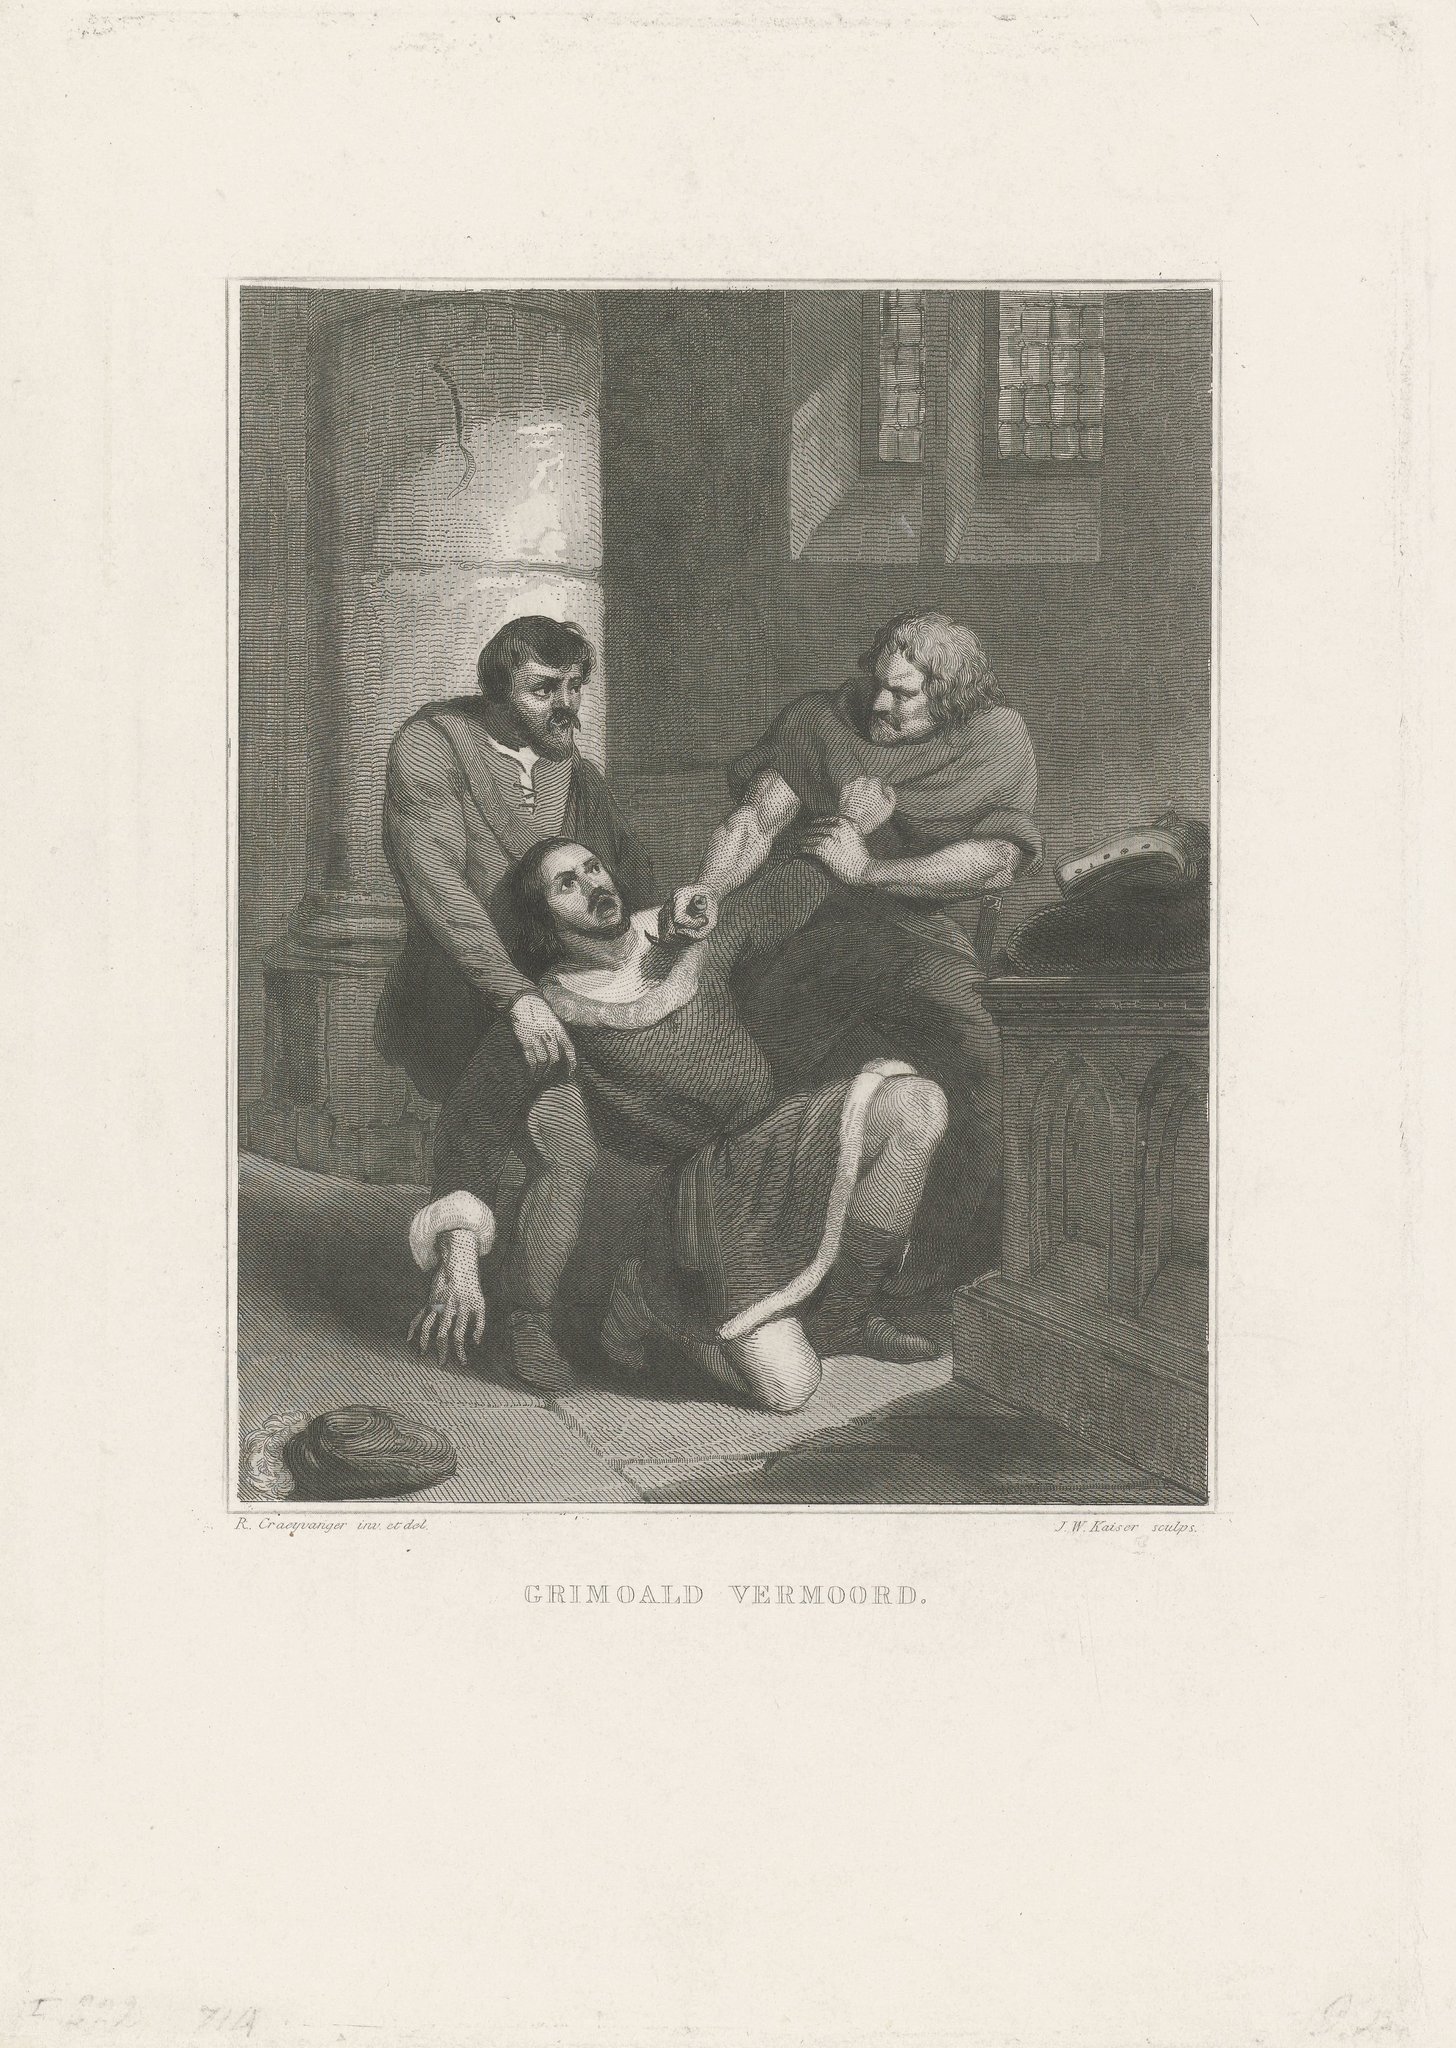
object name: book illustration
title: Grimoald vermoord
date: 1840-1884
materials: paper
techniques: etching, roulette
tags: murder, liège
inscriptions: collector's mark: Lugt 2228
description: Illustratie in: Arend, Johannes Pieter. Algemeene geschiedenis des vaderlands van de vroegste tijden tot op heden. 5 delen, Amsterdam: Schleijer, J.F. 1840-1884, dl 1, p. 322.